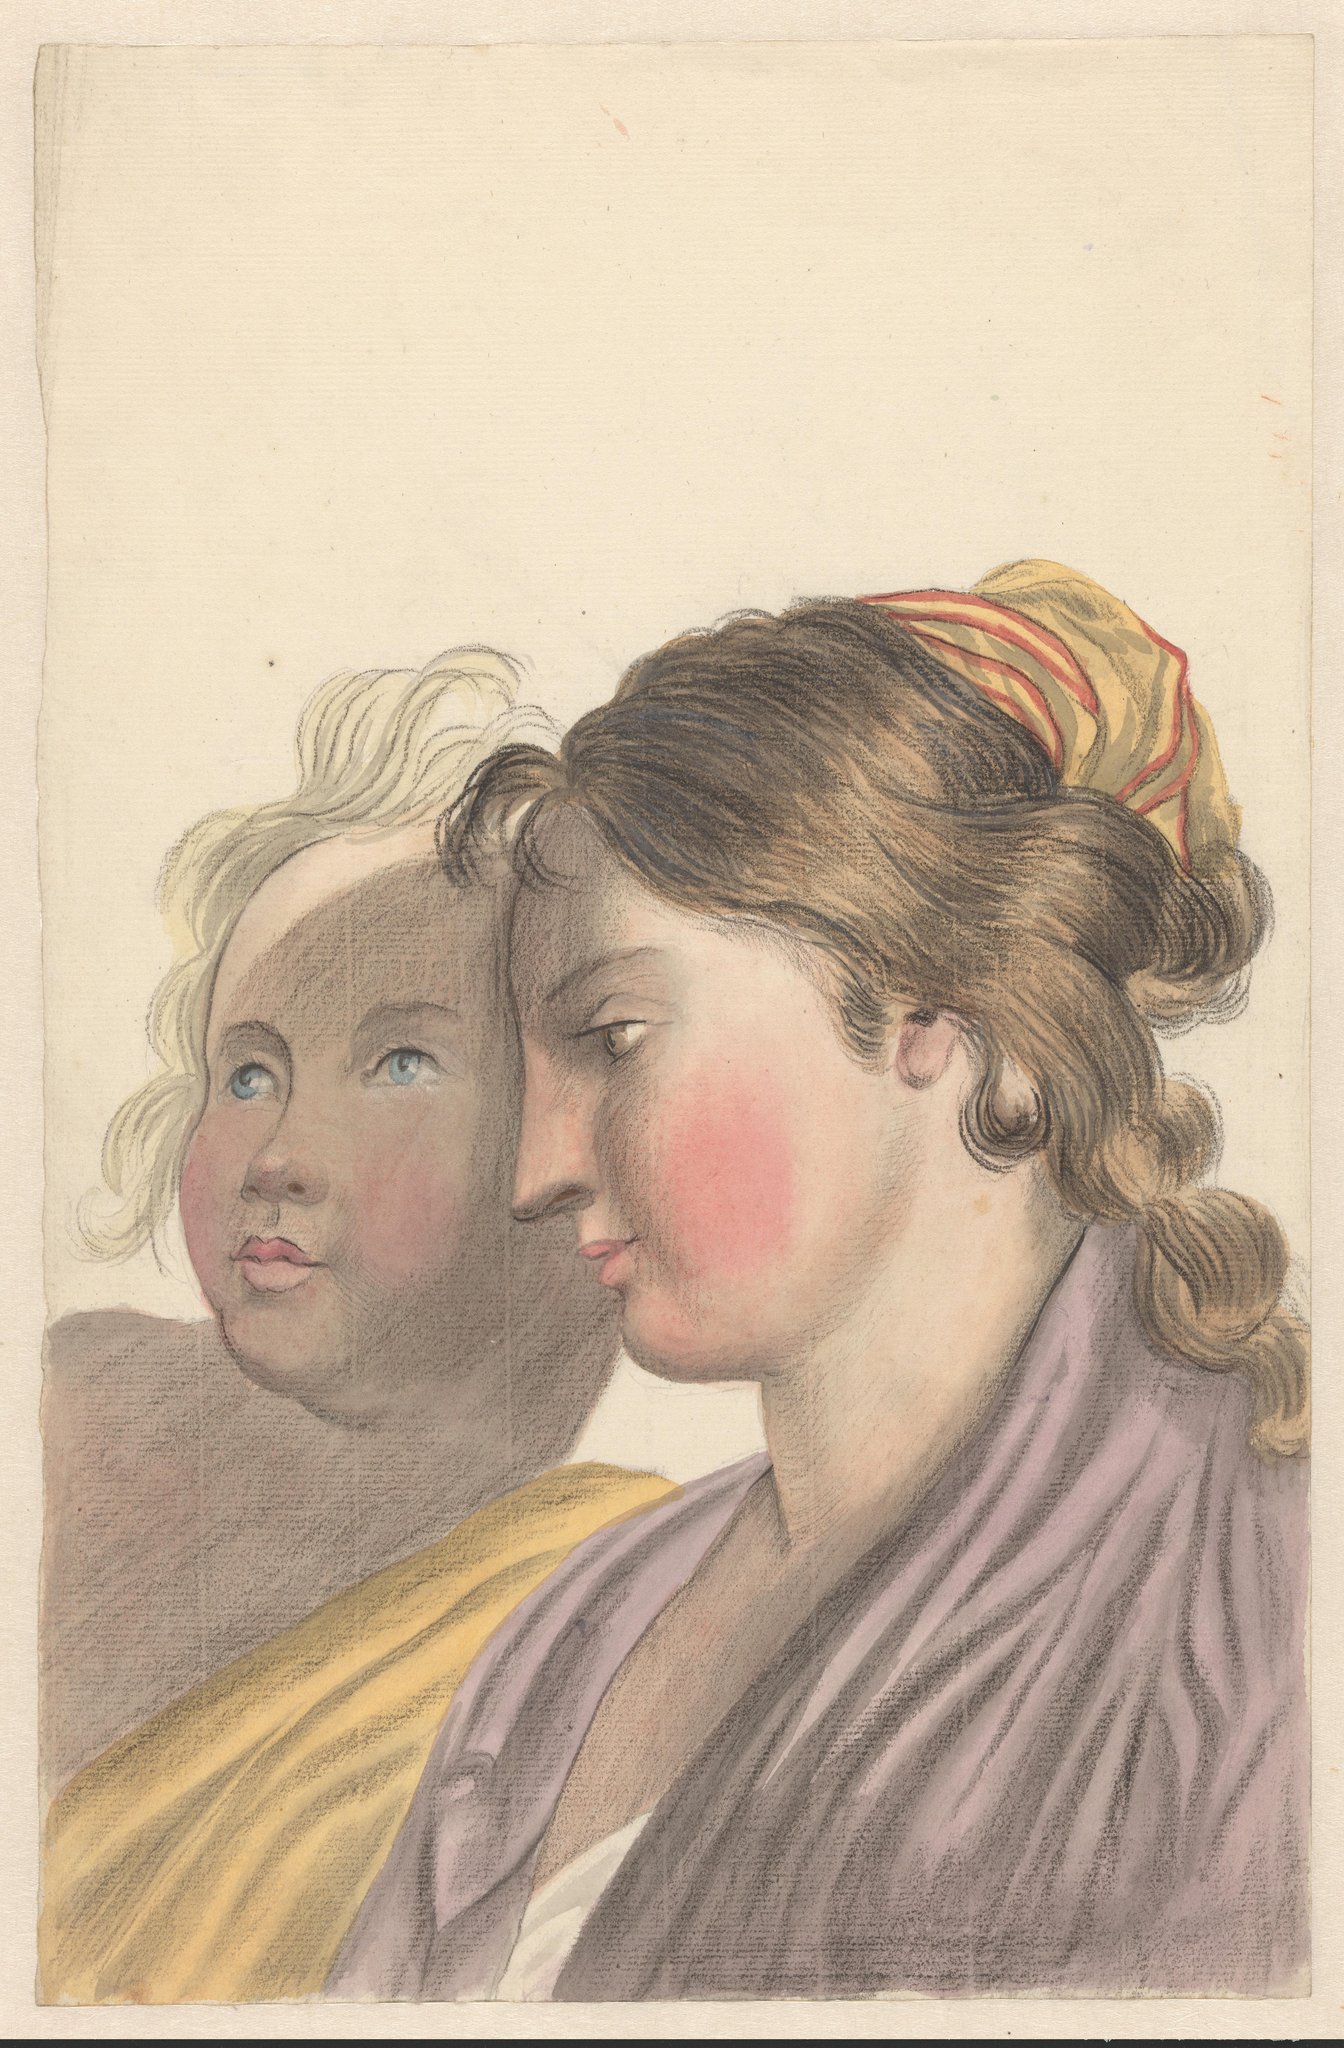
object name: drawing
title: Jonge vrouw en kind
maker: joannes carolus alberdingk thijm (jan)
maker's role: pater, schrijver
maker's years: 1847-1926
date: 1853-1860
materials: chalk, paper, pencil, watercolor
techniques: brush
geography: netherlands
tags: female sex; woman